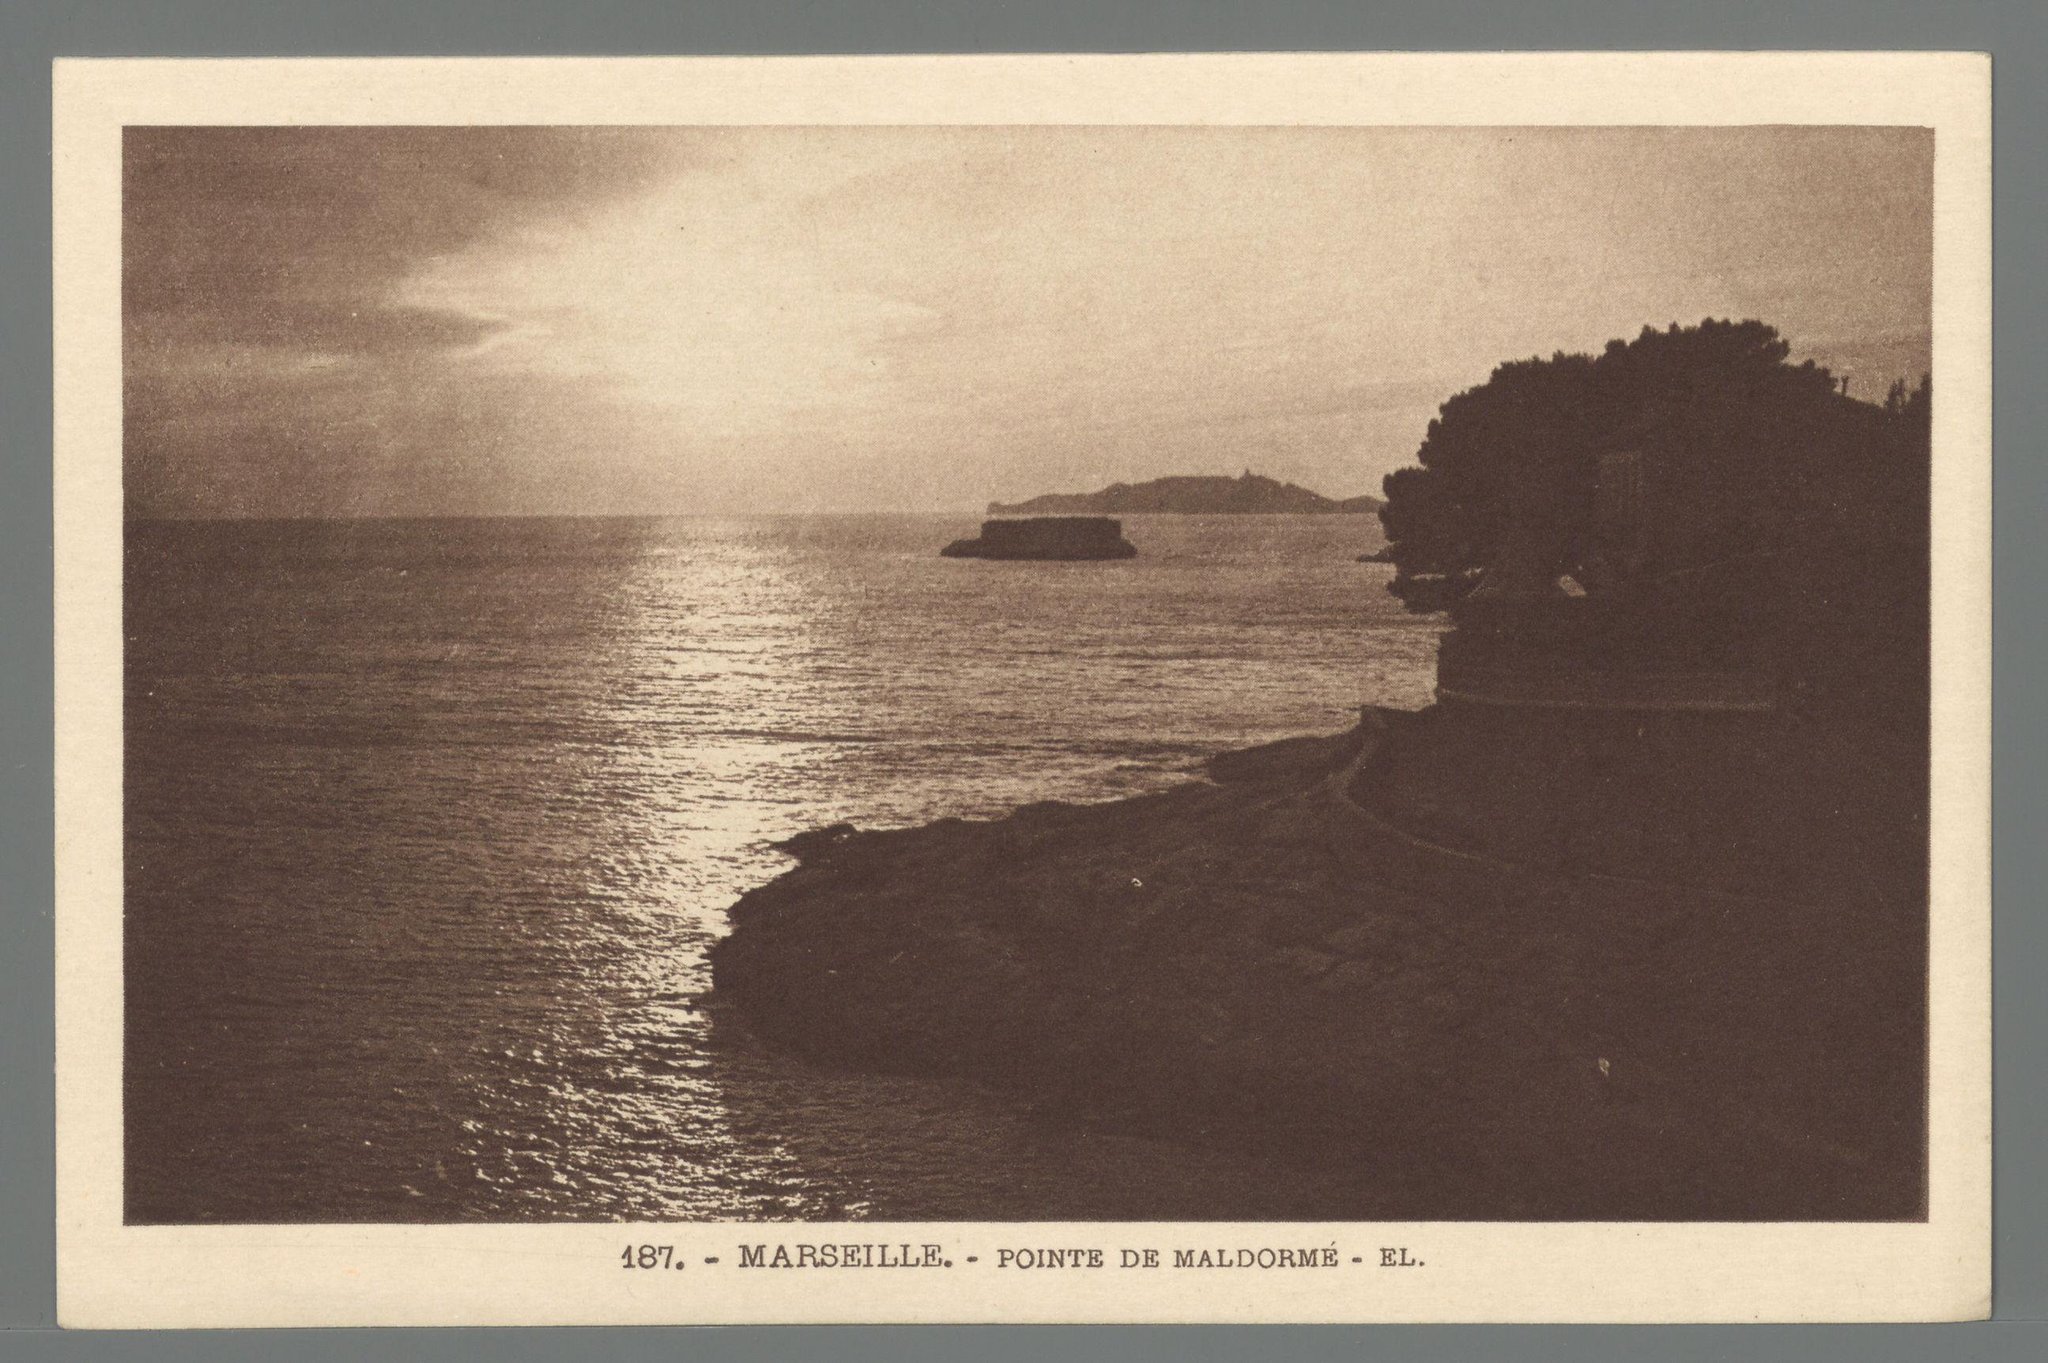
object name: photomechanical print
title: Marseille. Pointe de Maldormé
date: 1903-1913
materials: cardboard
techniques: rotogravure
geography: marseille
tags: dusk, evening twilight, rocky coast, marseille